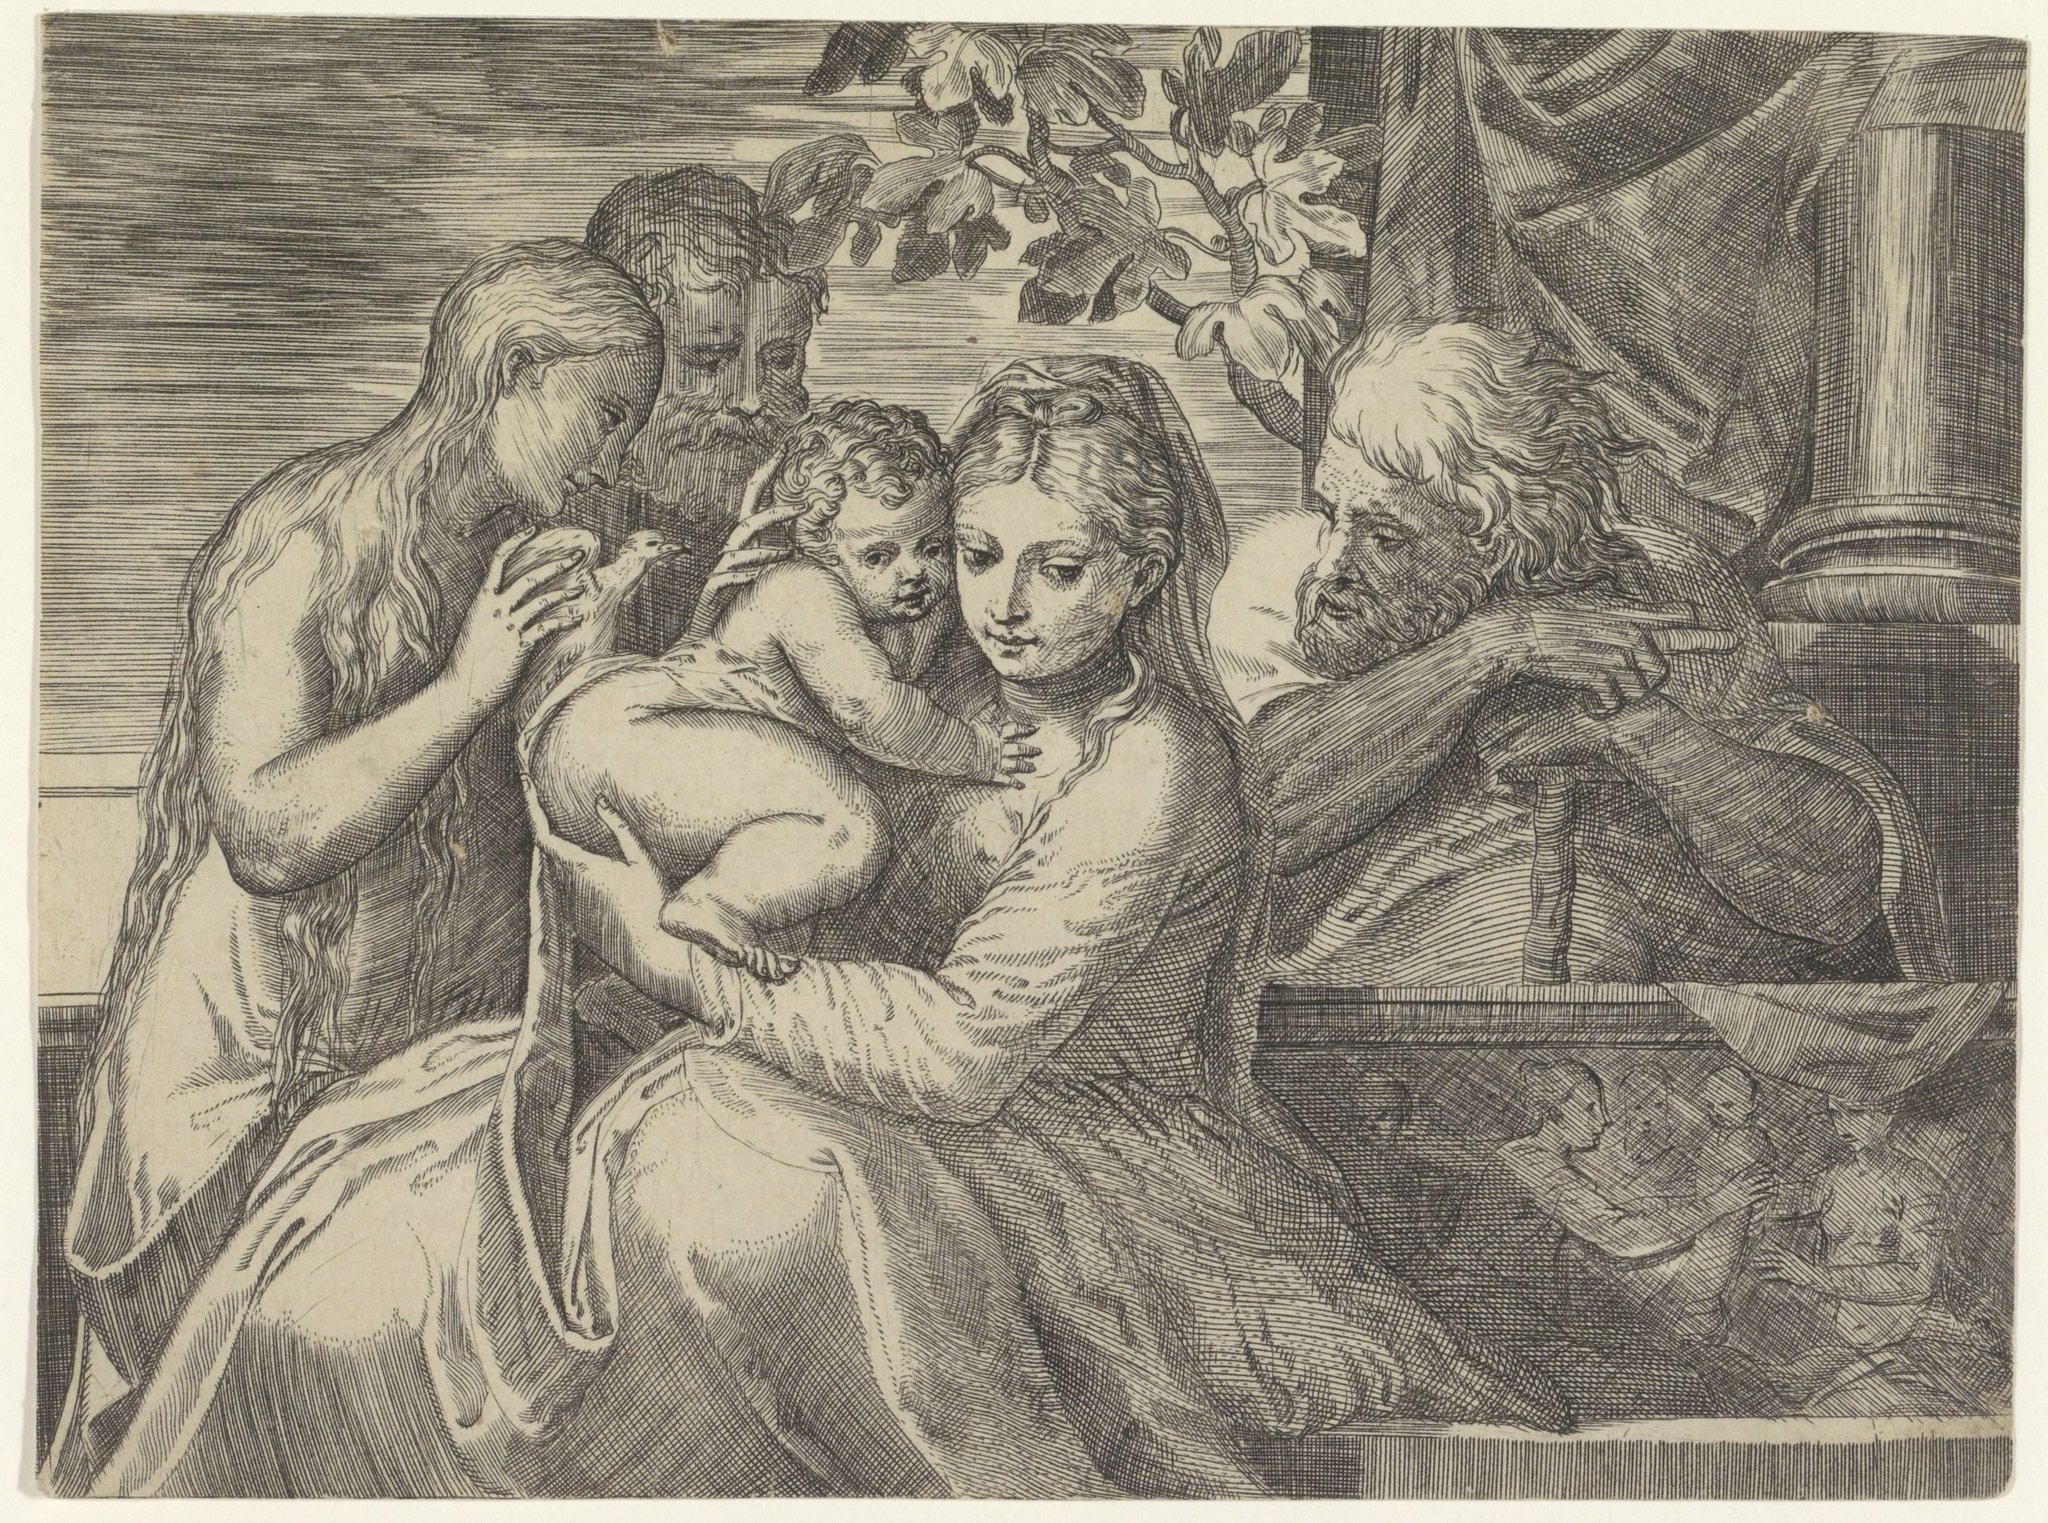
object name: print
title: Heilige Familie met heiligen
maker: battista angolo del moro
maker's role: print maker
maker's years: 1514-1575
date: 1524-1575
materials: paper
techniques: engraving, etching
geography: italy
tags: holy family with others, e.g.: anna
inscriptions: collector's mark: Lugt 2760, collector's mark: Lugt 2228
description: Maria zit met het Christuskind in haar armen. Jozef leunt achter haar op zijn stok. Links staan Maria Magdalena en een mannelijke heilige.